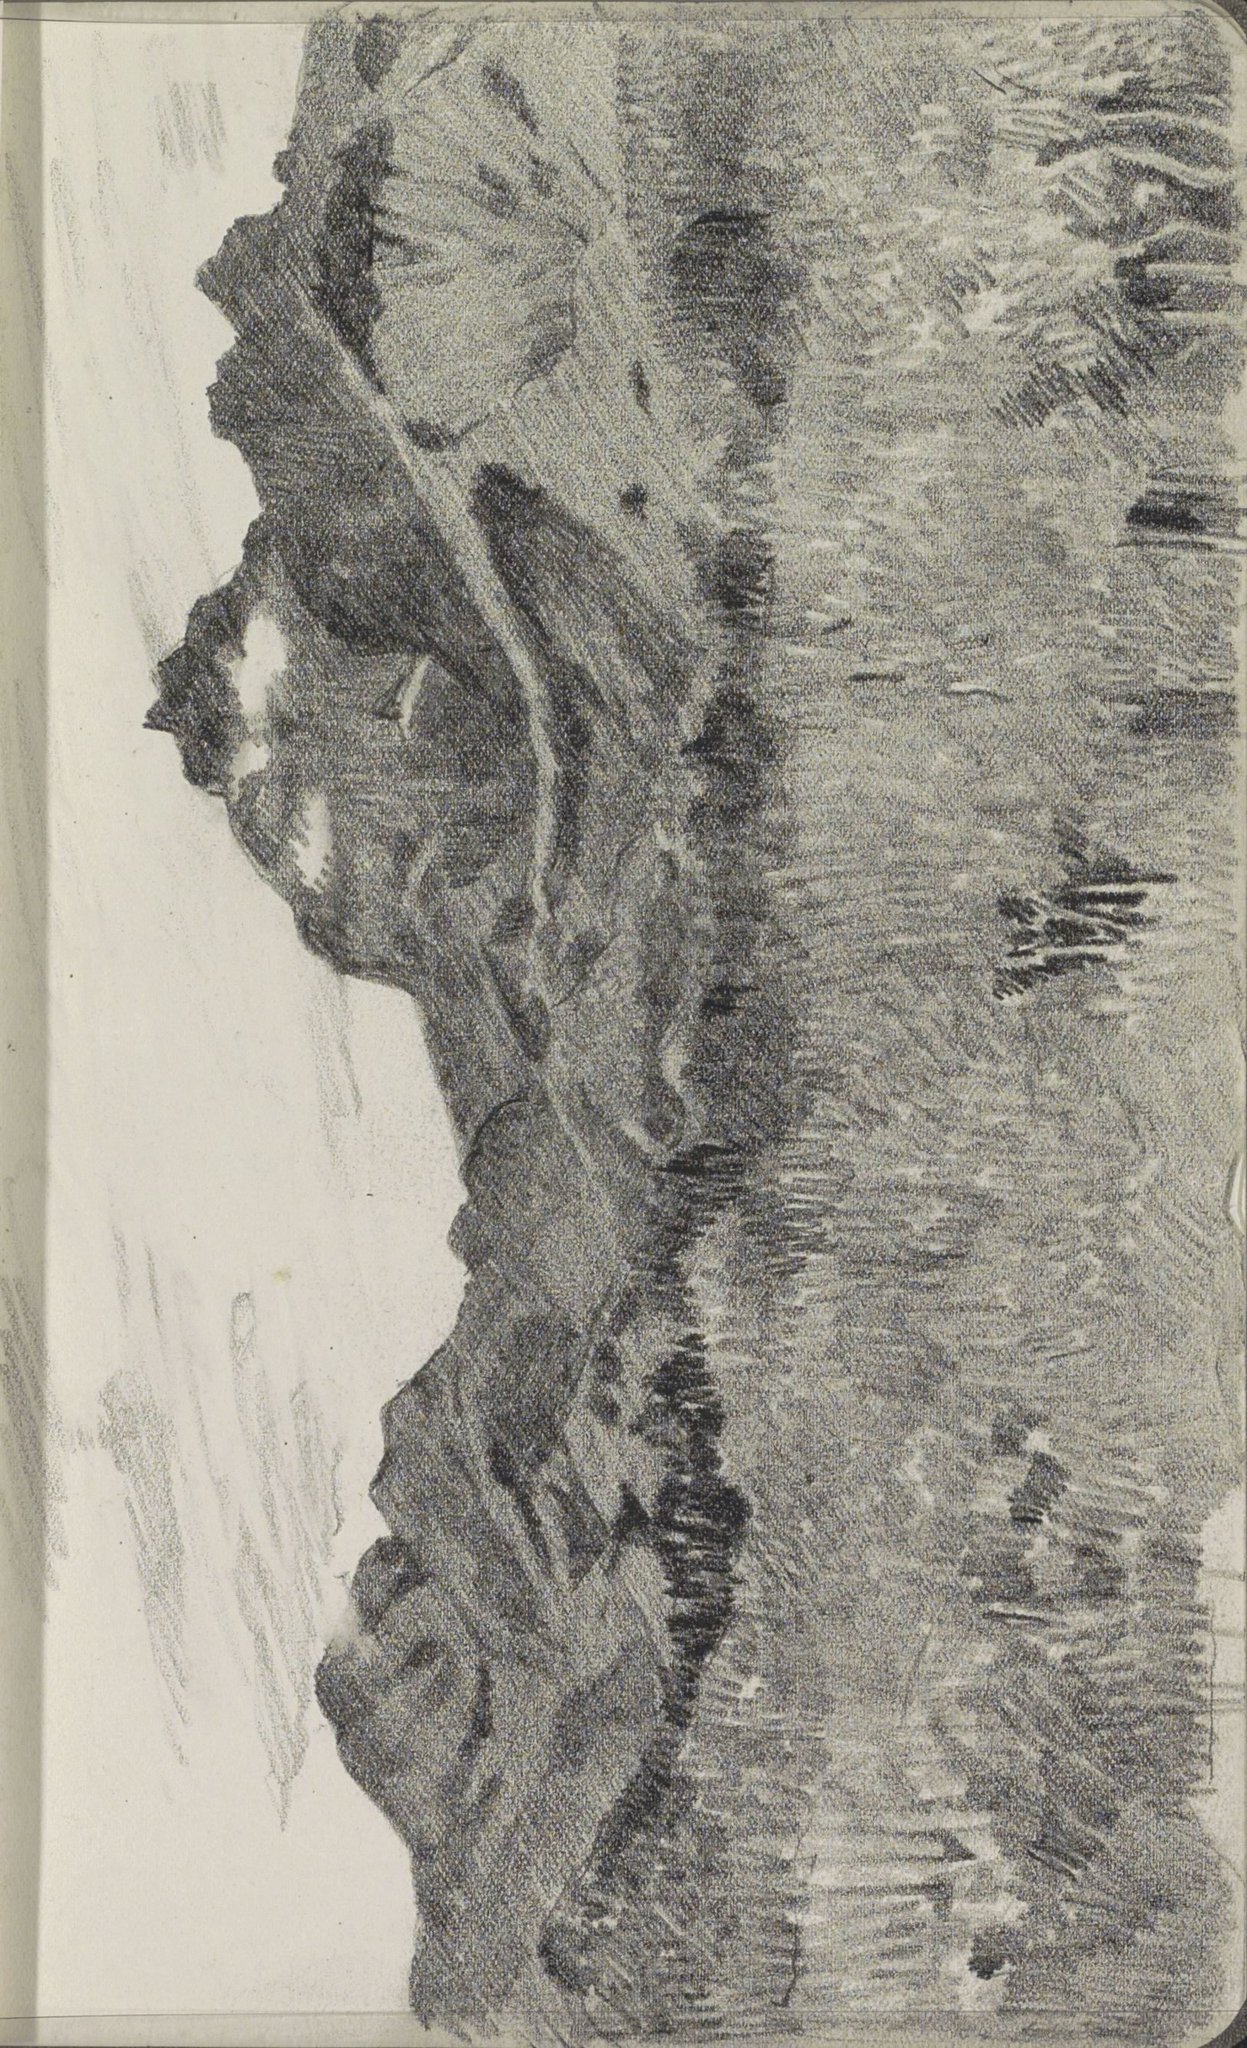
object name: sketchbook leaf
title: Heuvelachtig landschap, mogelijk te Gambar met de vulkaan De Kloet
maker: willem witsen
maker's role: draughtsman, painter, print maker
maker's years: 1860-1923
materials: paper, pencil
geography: east java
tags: (high) hill, volcano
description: Blad 30 uit een schetsboek met 75 bladen vervaardigd te Nederlands-Indië.